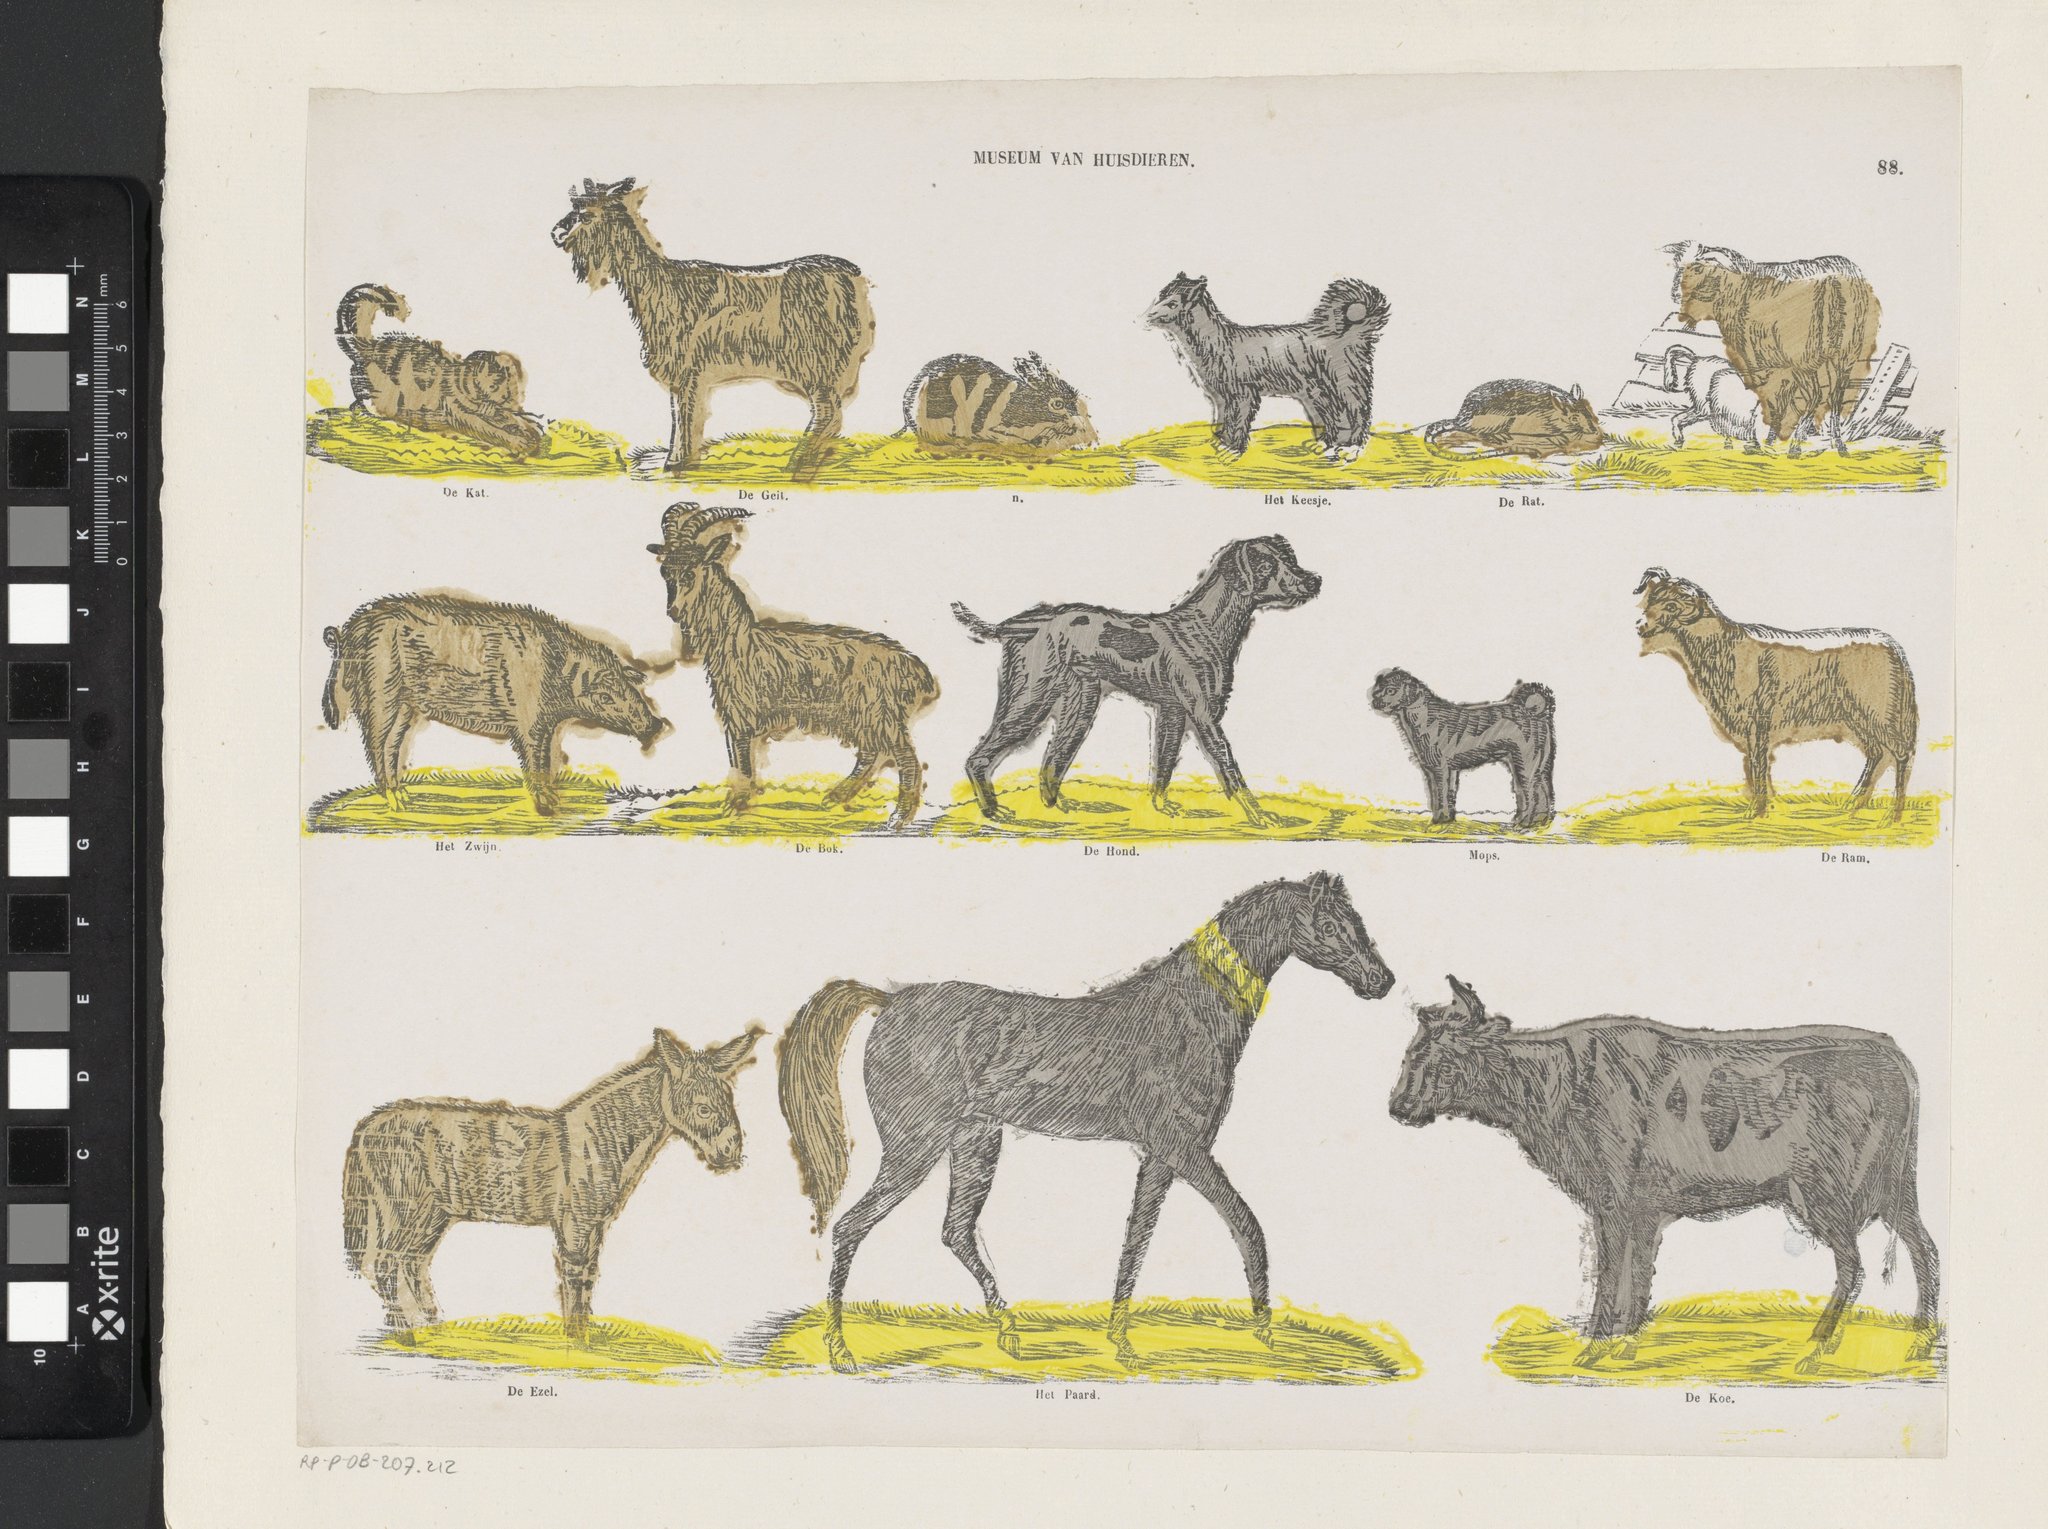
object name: popular print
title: Museum van huisdieren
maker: Anonymous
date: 1848-1881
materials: paper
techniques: colour, letterpress printing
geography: den bosch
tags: cow, animals, cat, horse, goat, dog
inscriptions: collector's mark: Lugt 2760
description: Blad met 3 hotrizontale rijen met voorstellingen van dieren, zoals een kat, een geit en een konijn. Onder elke voorstelling een onderschrift. Genummerd rechtsboven: 88.